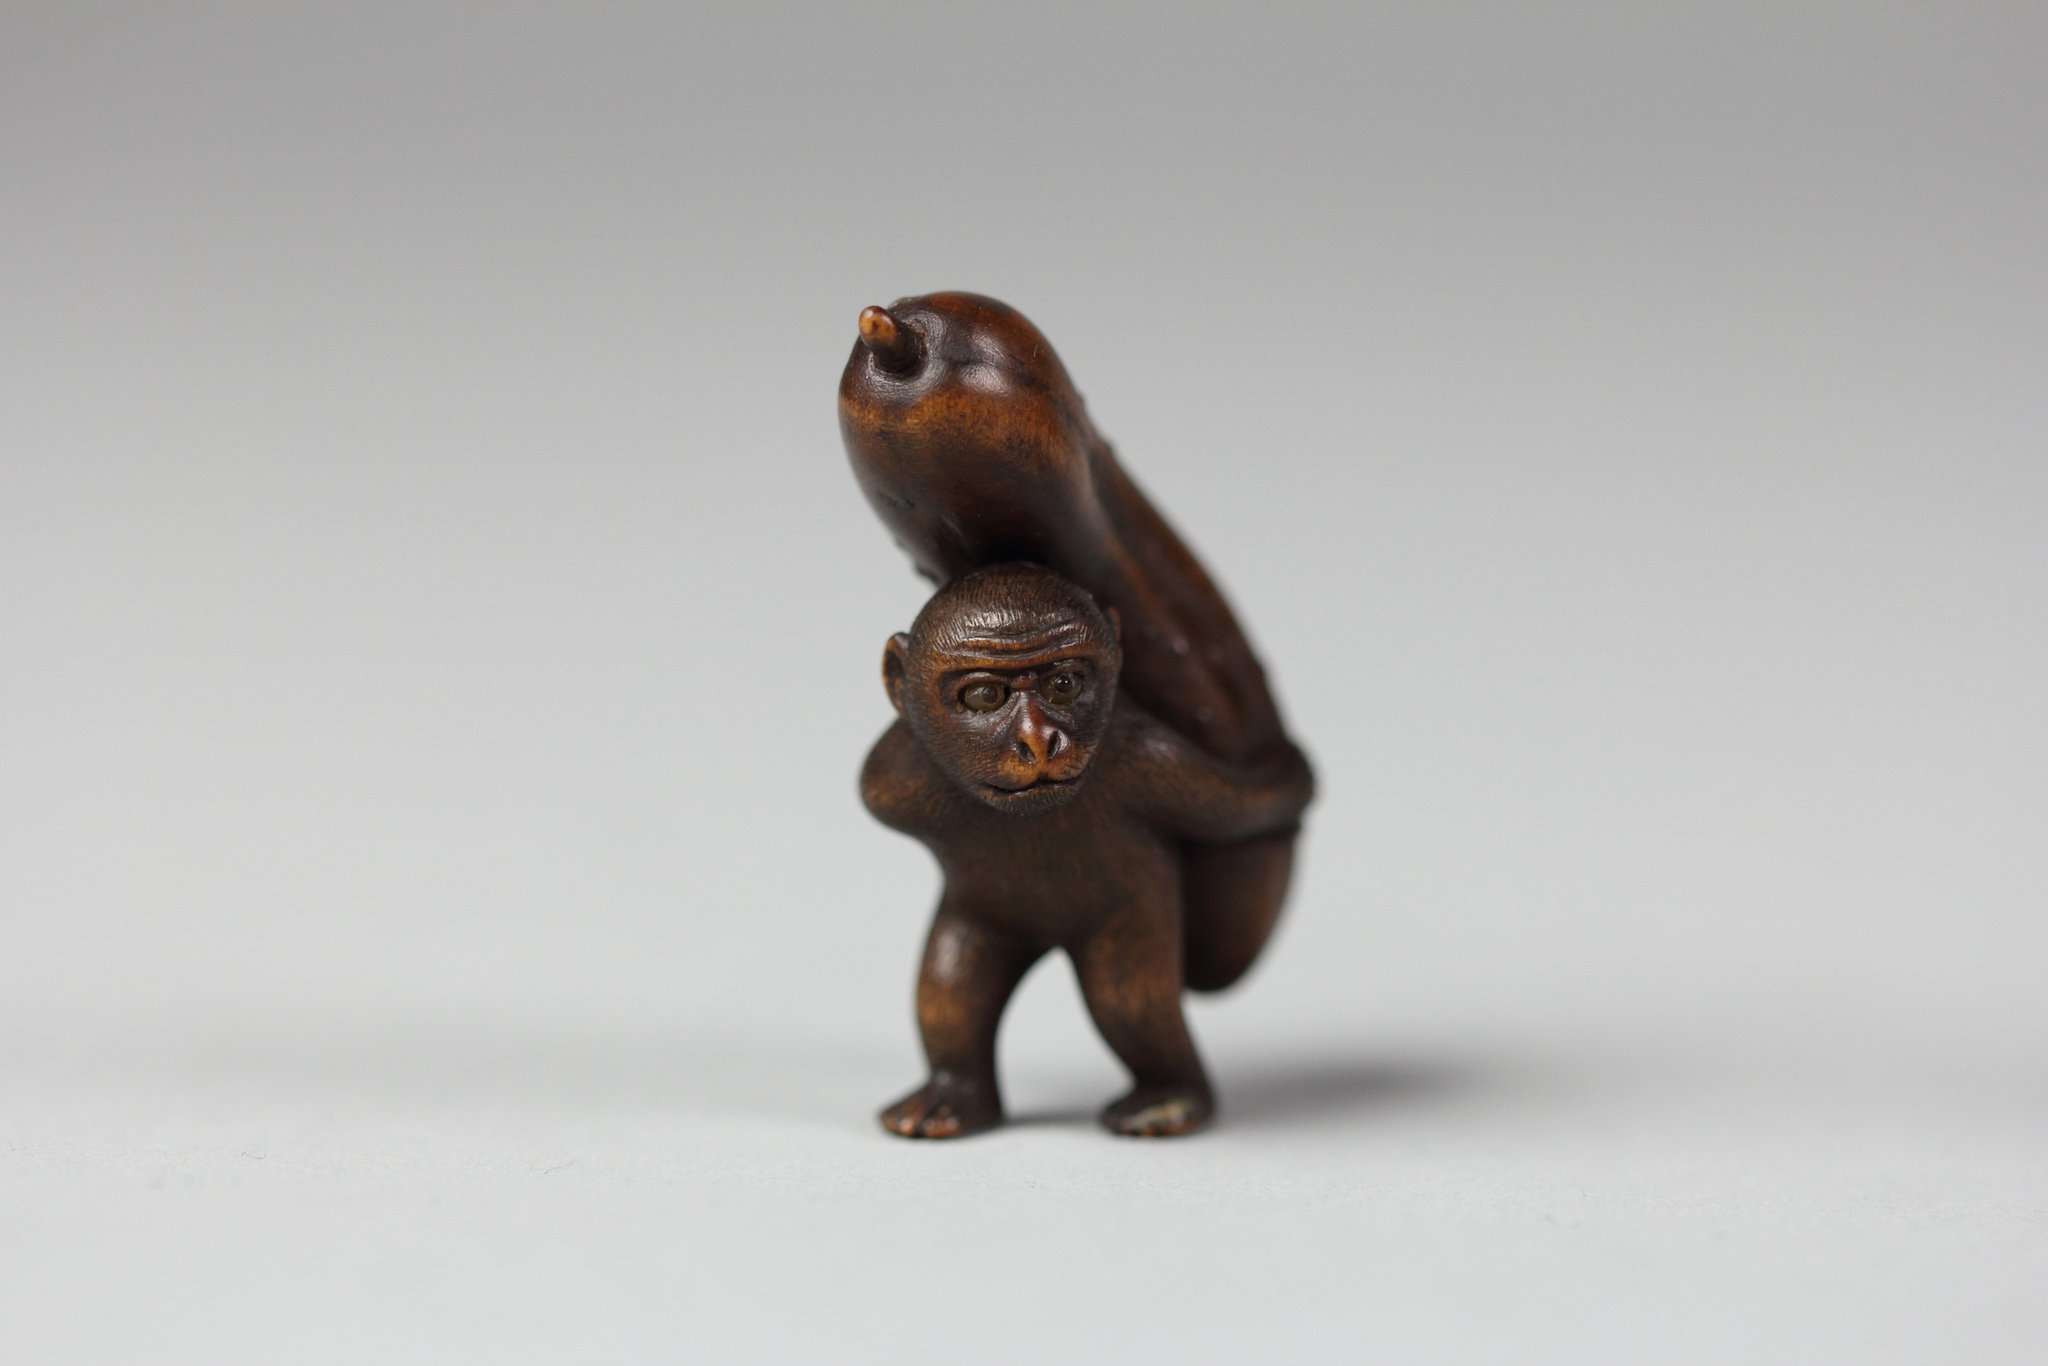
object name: netsuke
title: Netsuke of Monkey Carrying a Cucumber on His Back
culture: japanese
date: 1801-1900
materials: wood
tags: vegetables,monkeys